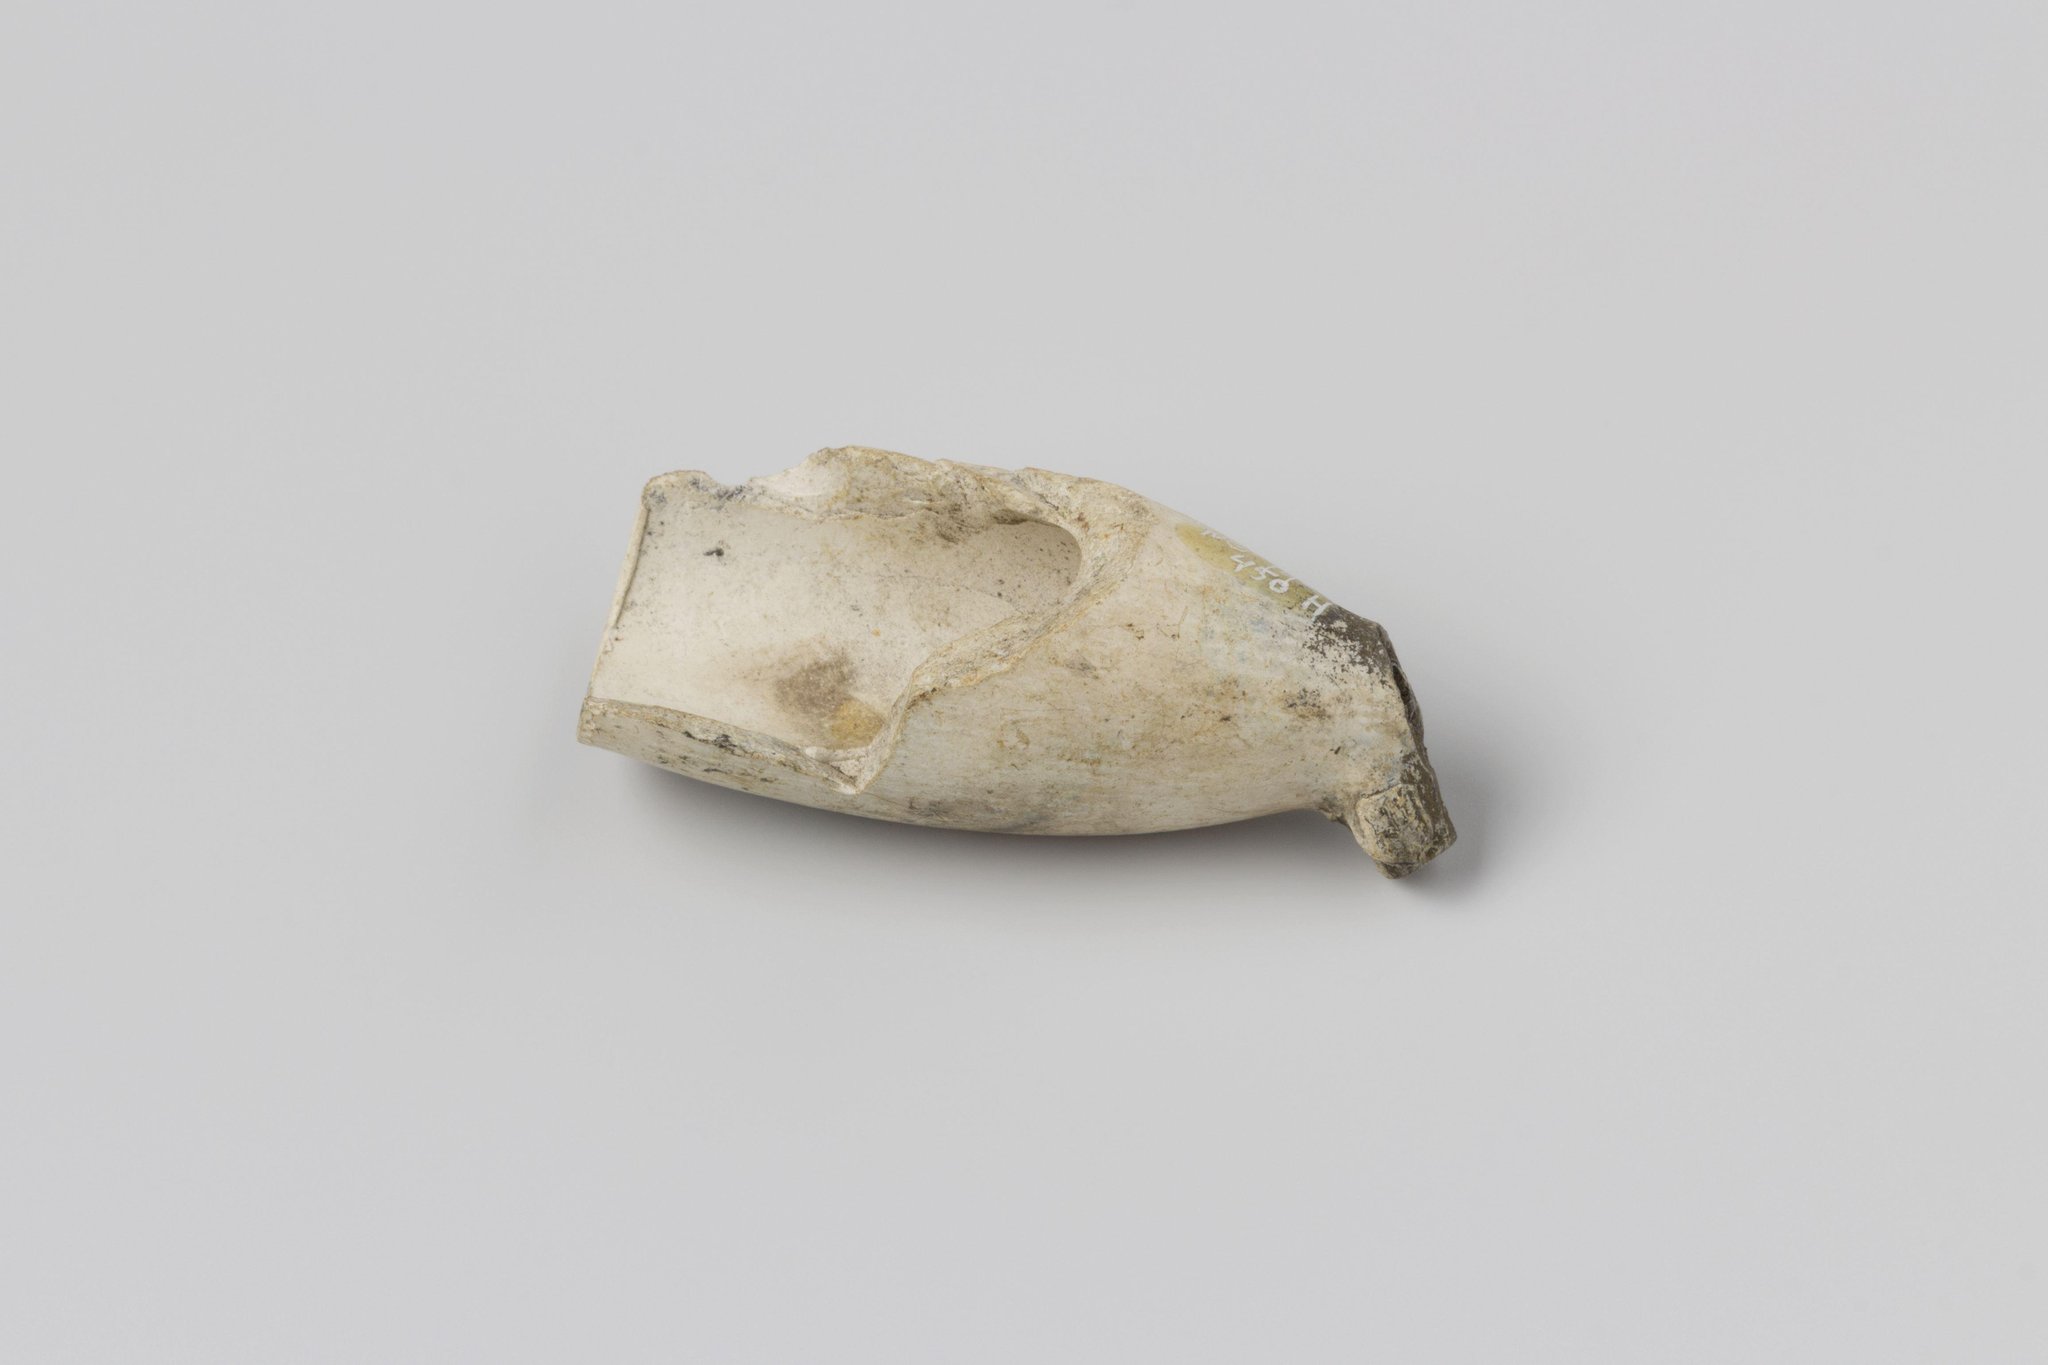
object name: pipe bowl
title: Fragment pijpenkop uit het wrak van de Oost-Indiëvaarder Hollandia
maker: Anonymous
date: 1700-1743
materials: clay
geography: netherlands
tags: verenigde oostindische compagnie, hollandia (schip), annet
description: Pipe, bowl, heelmark: fish, flounder; fragm, 2hsm1,6.